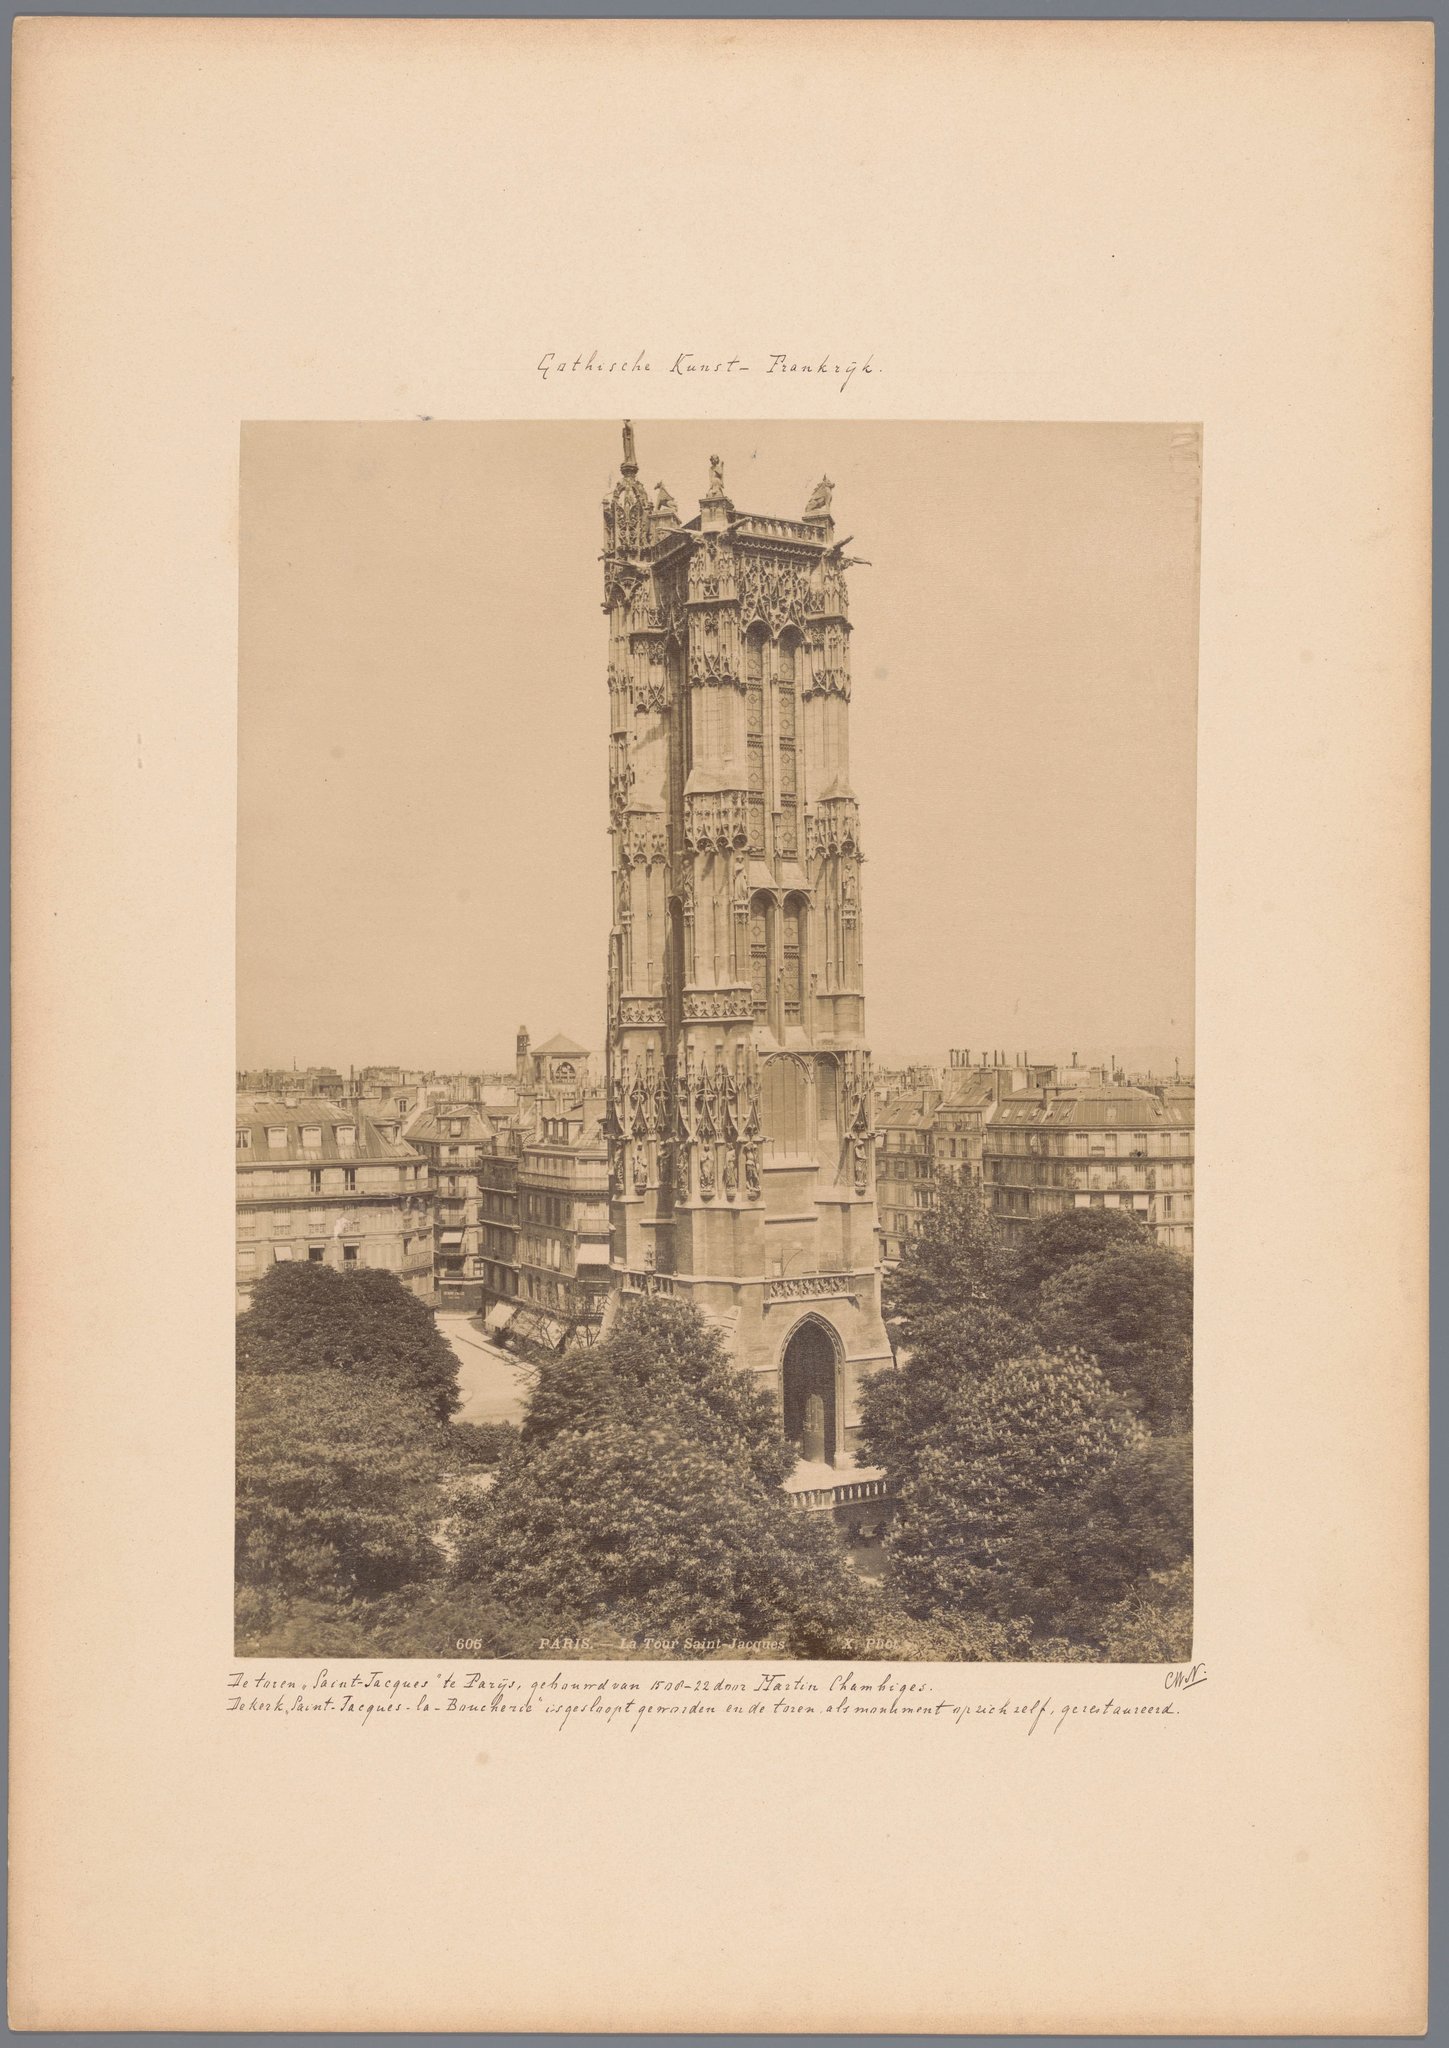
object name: photograph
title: Gezicht op de Tour Saint-Jacques te Parijs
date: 1875-1900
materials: cardboard, photographic support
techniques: albumen print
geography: paris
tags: tower, clock tower ~ monumental adornment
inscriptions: collector's mark: ‘KUNSTNIJVERHEIDSCHOOL QUELLINUS AMSTERDAM FRANS HALSSTRAAT 14.’, inscription: ‘T&M’, collector's mark: ‘INSTITUUT VOOR KUNST-NIJVERHEIDSONDERWIJS GABRIËL METSUSTRAAT No. 16 AMSTERDAM’, inscription: ‘CWN.’, number: ‘605’, inscription: ‘Gothische Kunst - Frankrijk.’